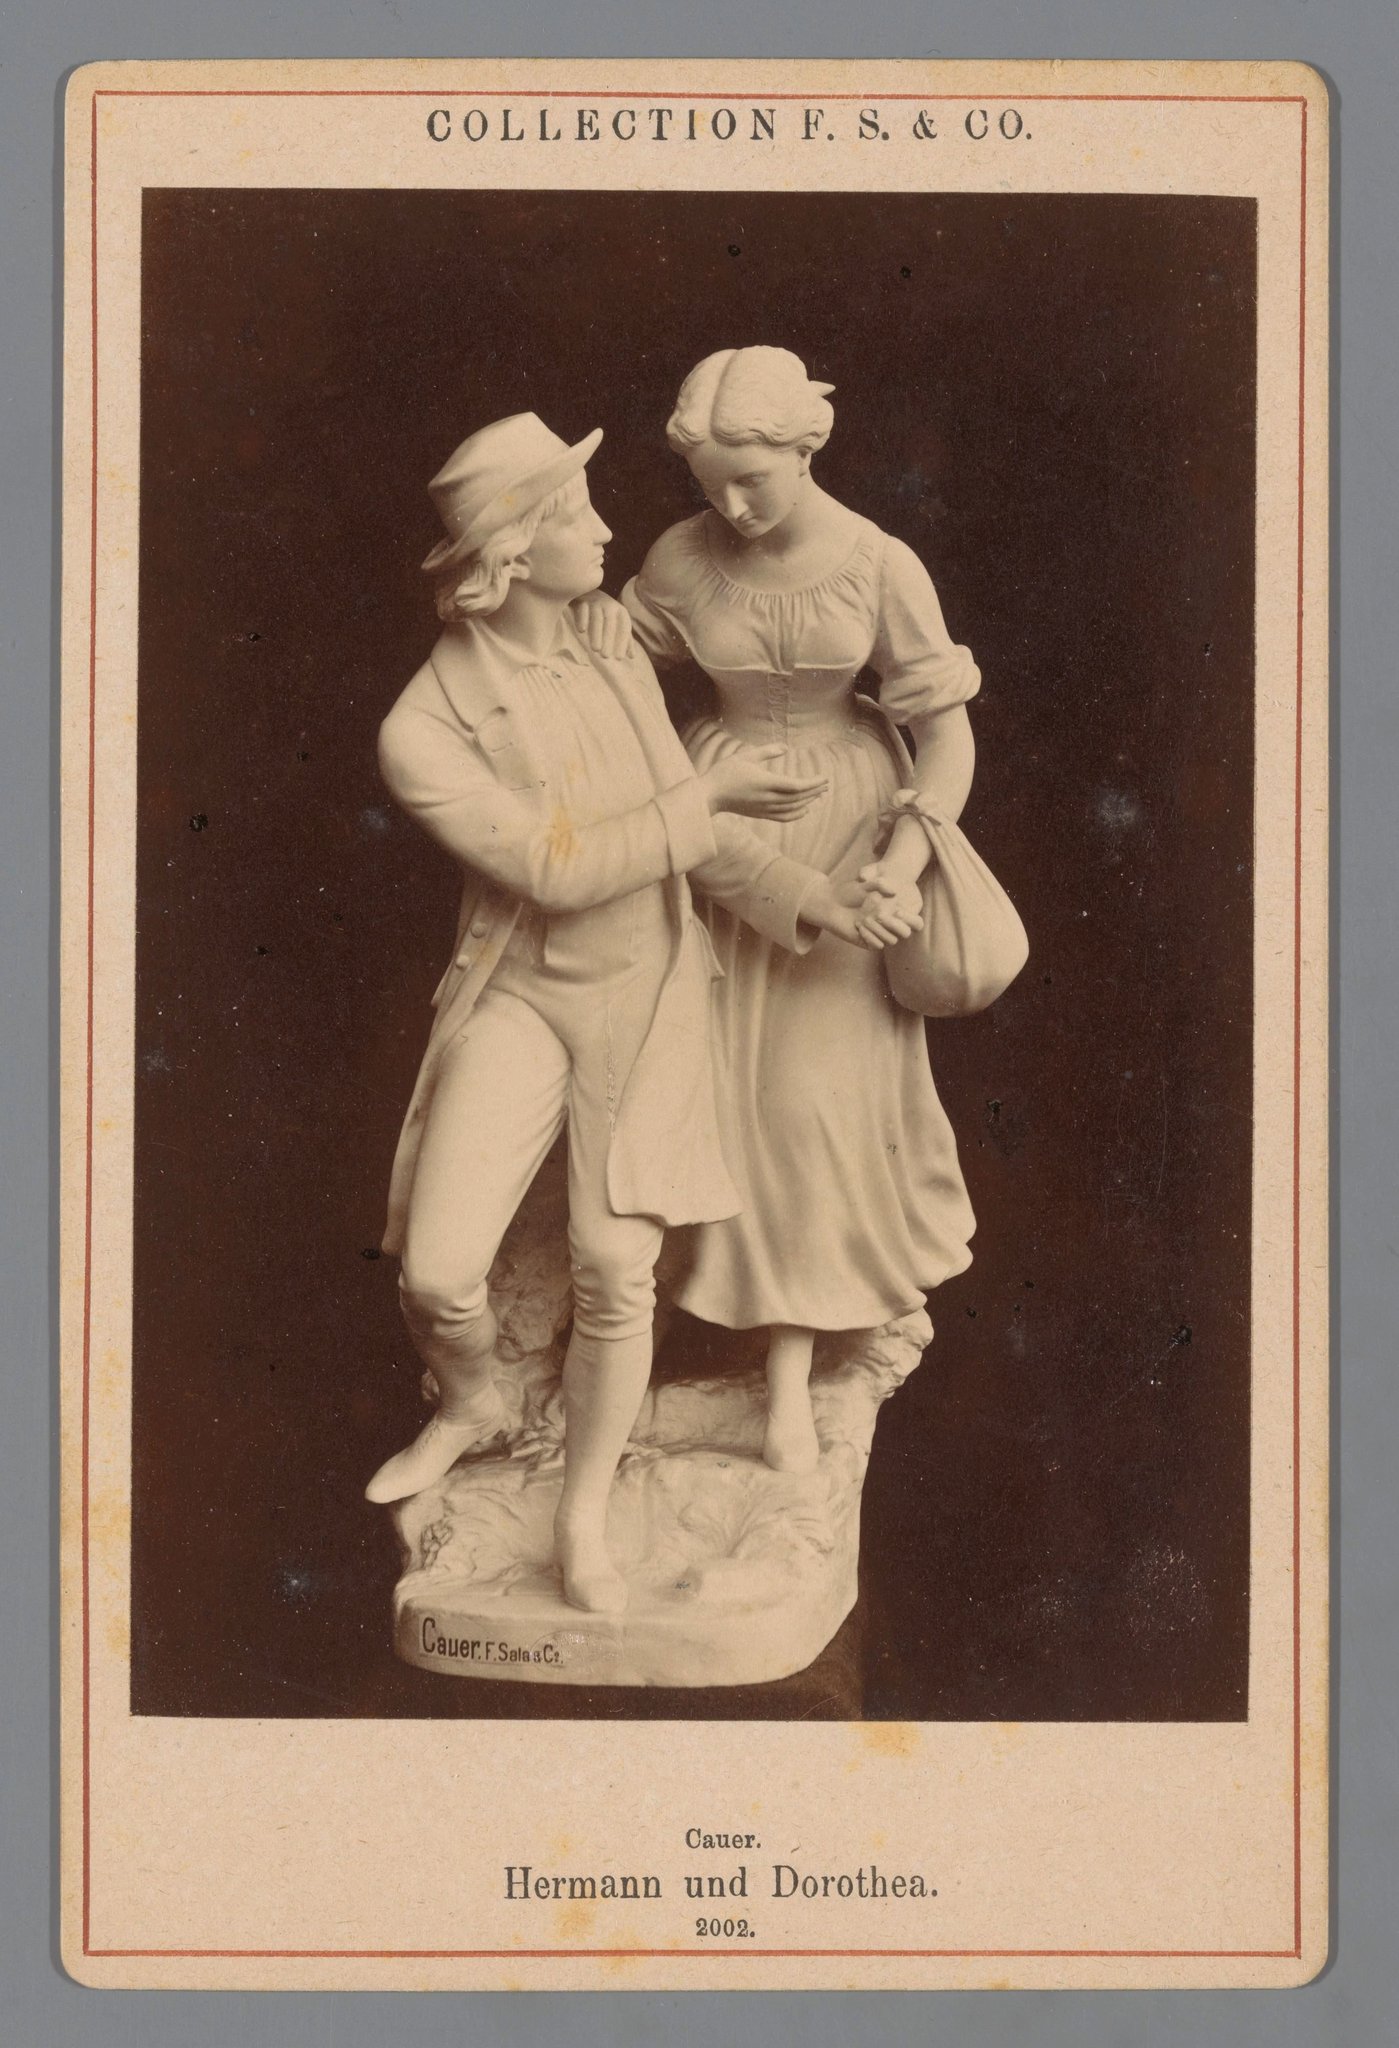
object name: cabinet photograph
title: Hermann und Dorothea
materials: cardboard, photographic support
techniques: albumen print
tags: piece of sculpture, reproduction of a piece of sculpture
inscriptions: inscription: ‘Souvenir de lors affectionnée [...] 17. jullet 78. Baarn.’, number: ‘2002.’